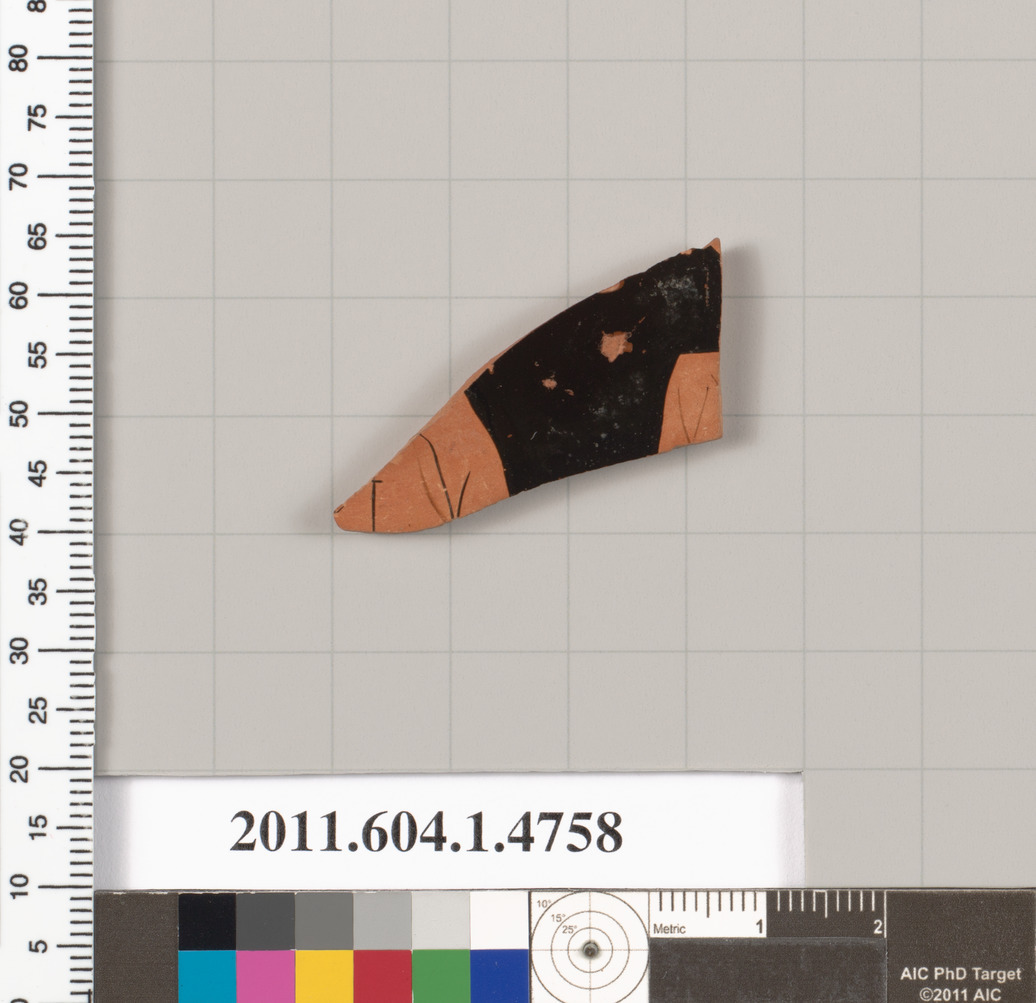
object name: kylix fragment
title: Terracotta fragment of a kylix (drinking cup)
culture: greek, attic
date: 467-435 BCE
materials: terracotta